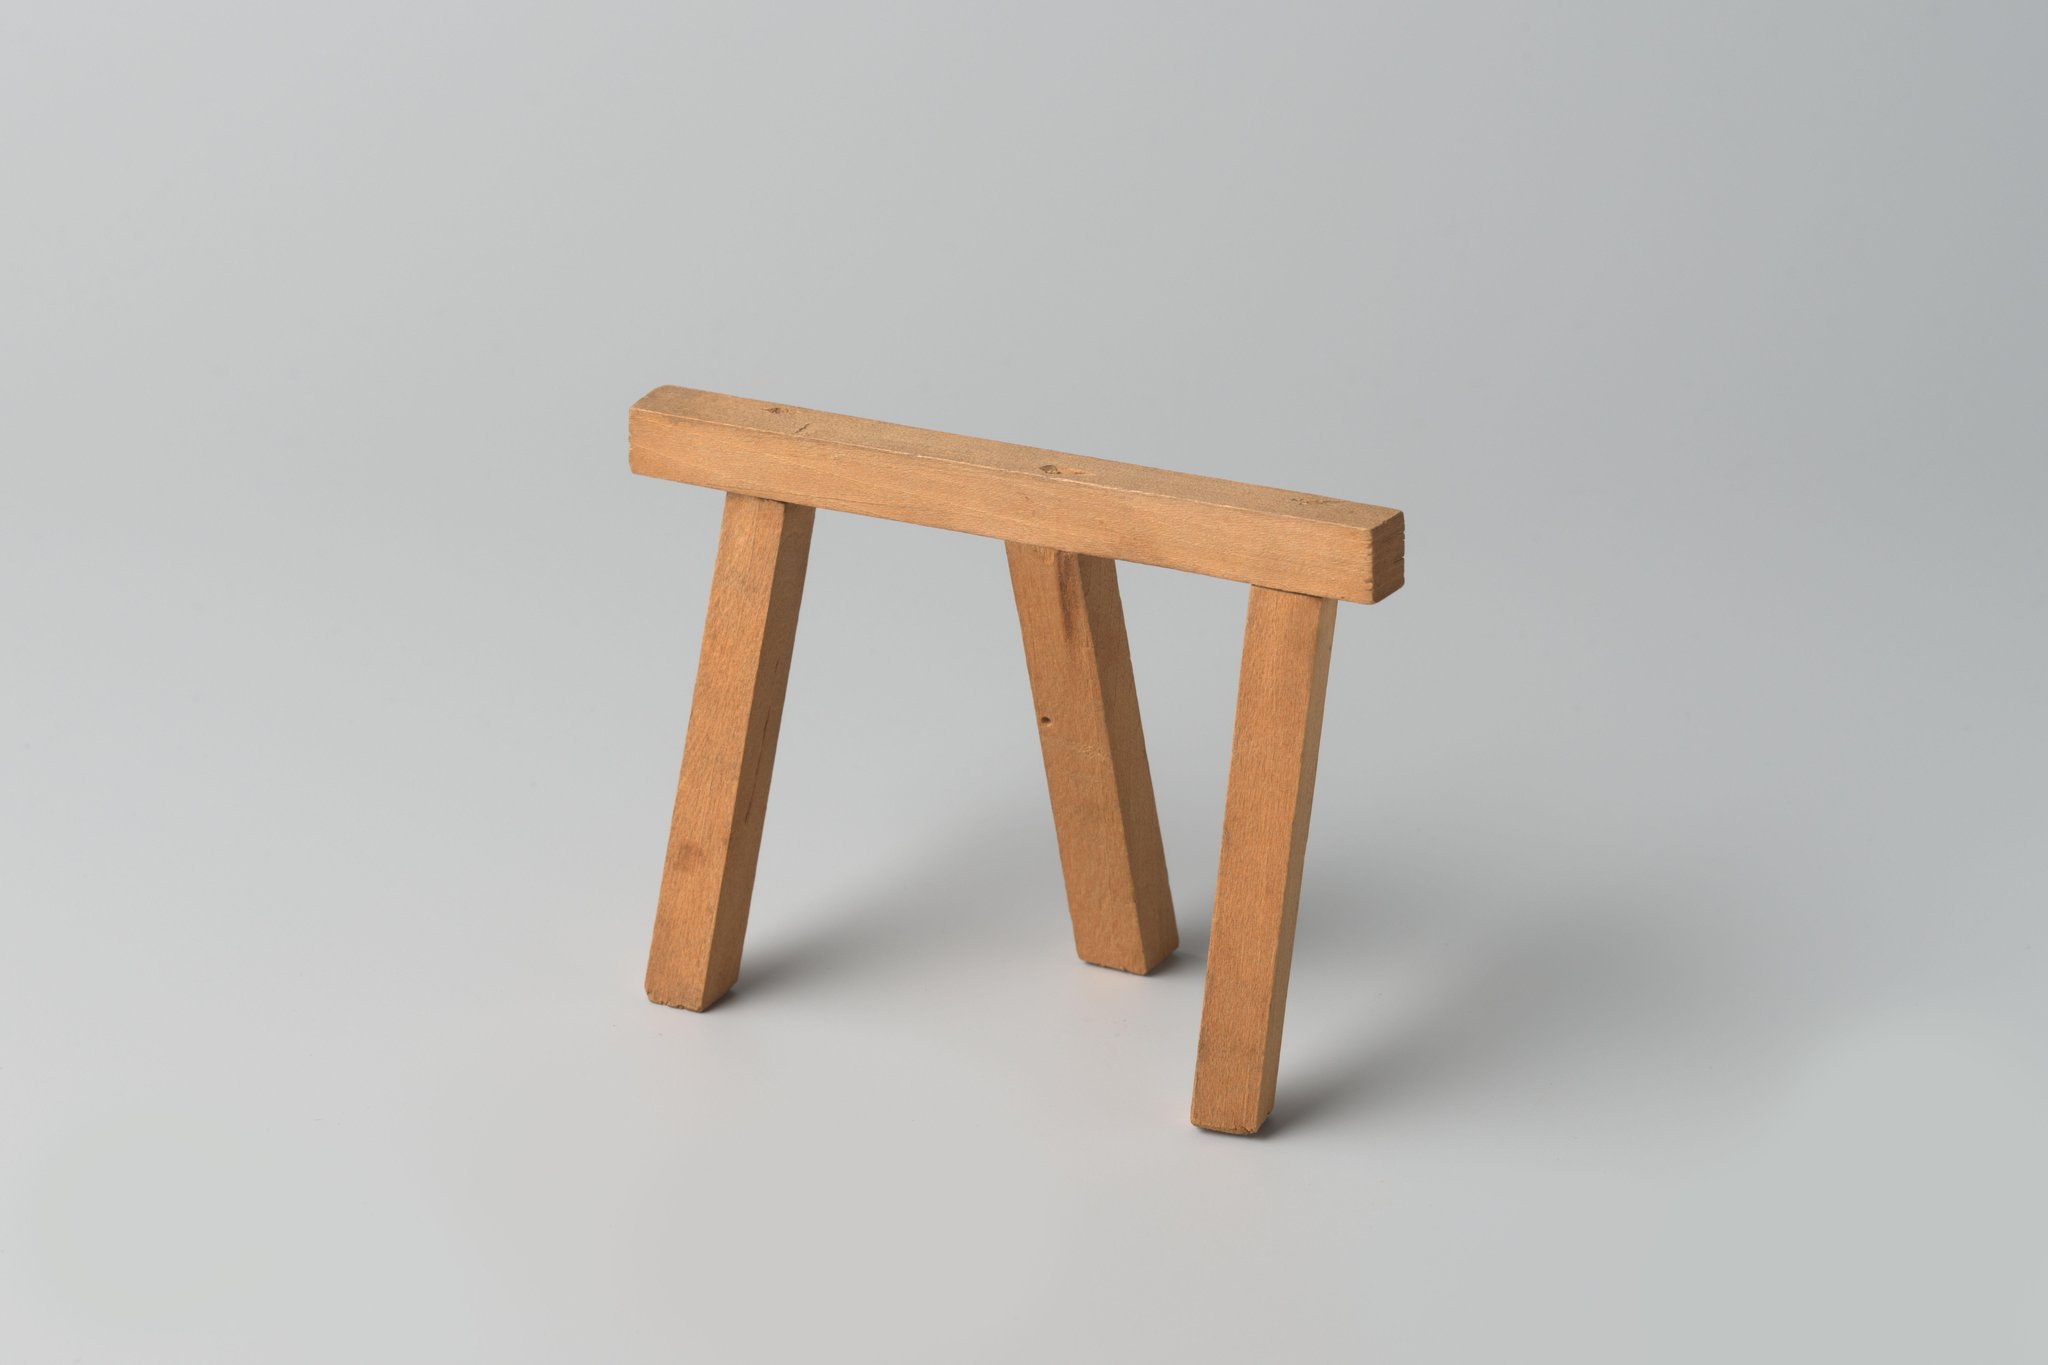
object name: miniature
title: Schraag van without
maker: Anonymous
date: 1676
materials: without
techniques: without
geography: amsterdam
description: Schraag vervaardigd van without, bestaande uit een horizontale balk en drie schuinstaande poten gemaakt van without, door metalen nagels verbonden.